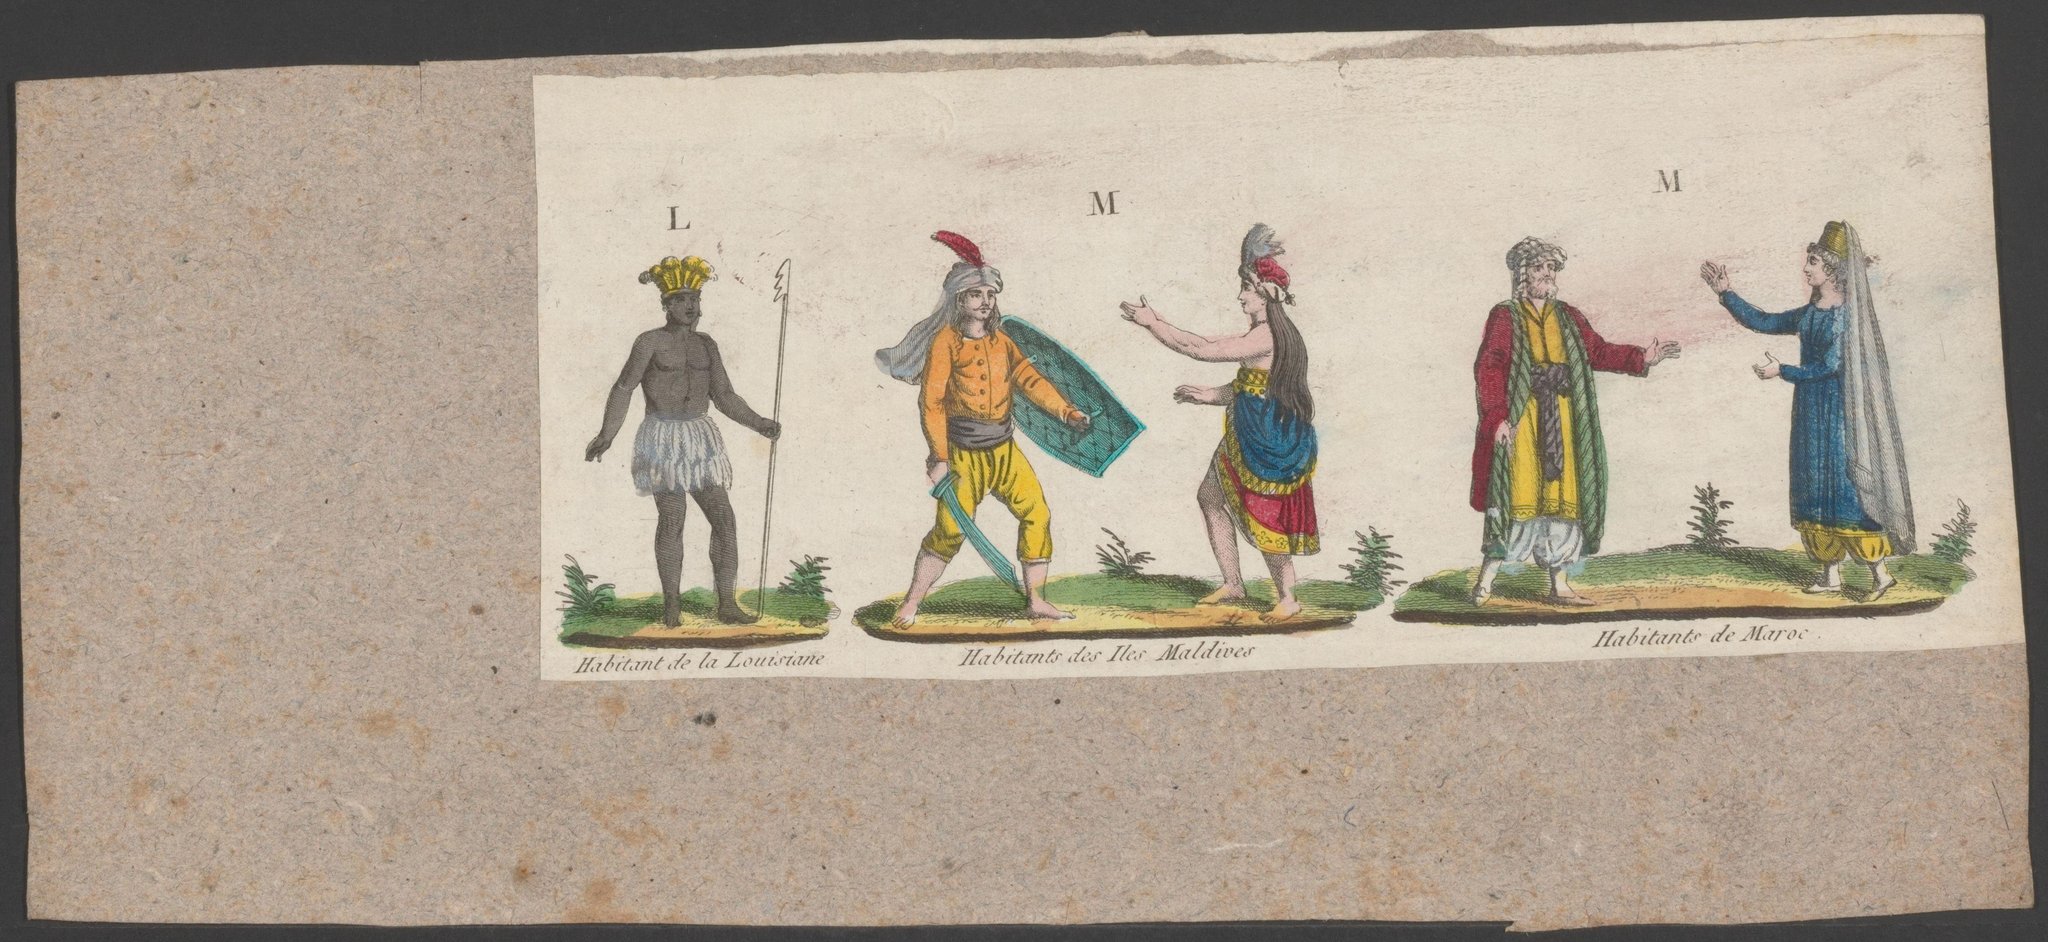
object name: print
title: Klederdracht van de bewoners van Louisiana, Maladiven en Marokko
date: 1750-1865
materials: paper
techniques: hand coloring, lithograph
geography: paris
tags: historical costume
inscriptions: stamp, collector's mark: Lugt 1641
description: Onderwerpsrubrieken binnen de Atlas Zeden en Gewoonten: Zeden en gewoonten in engeren zin, Des menschen begin, midden en einde, Kinderprenten opgeplakt op karton.